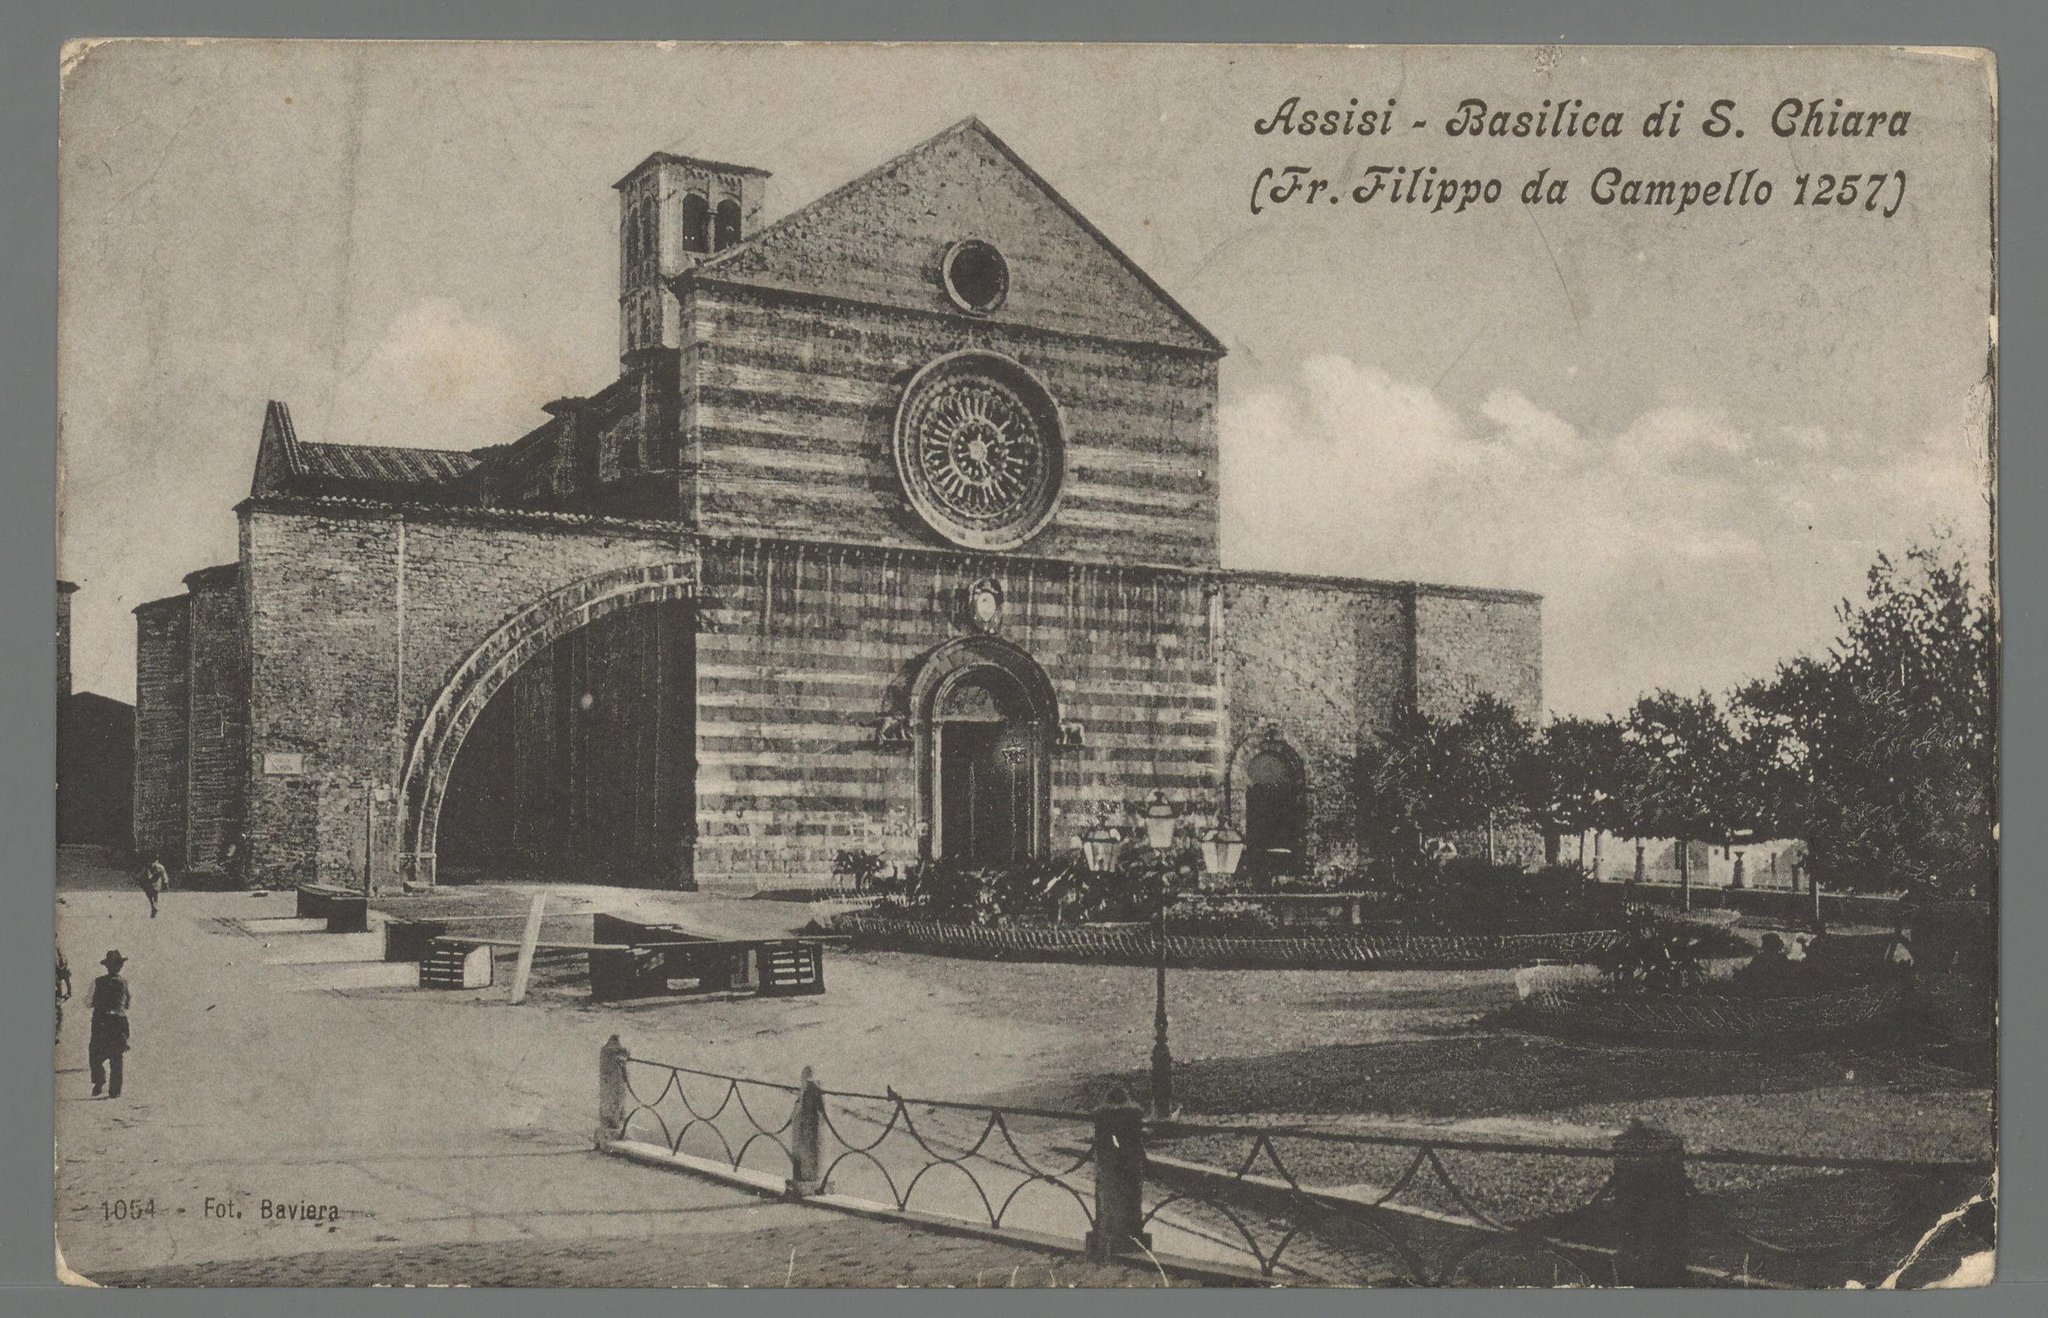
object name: photomechanical print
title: Assisi. Basilica di S. Chiara (Fr. Filippo da Campello 1257)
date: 1906-1921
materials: cardboard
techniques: photograph, writing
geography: jesi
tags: church (exterior)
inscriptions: postage stamp